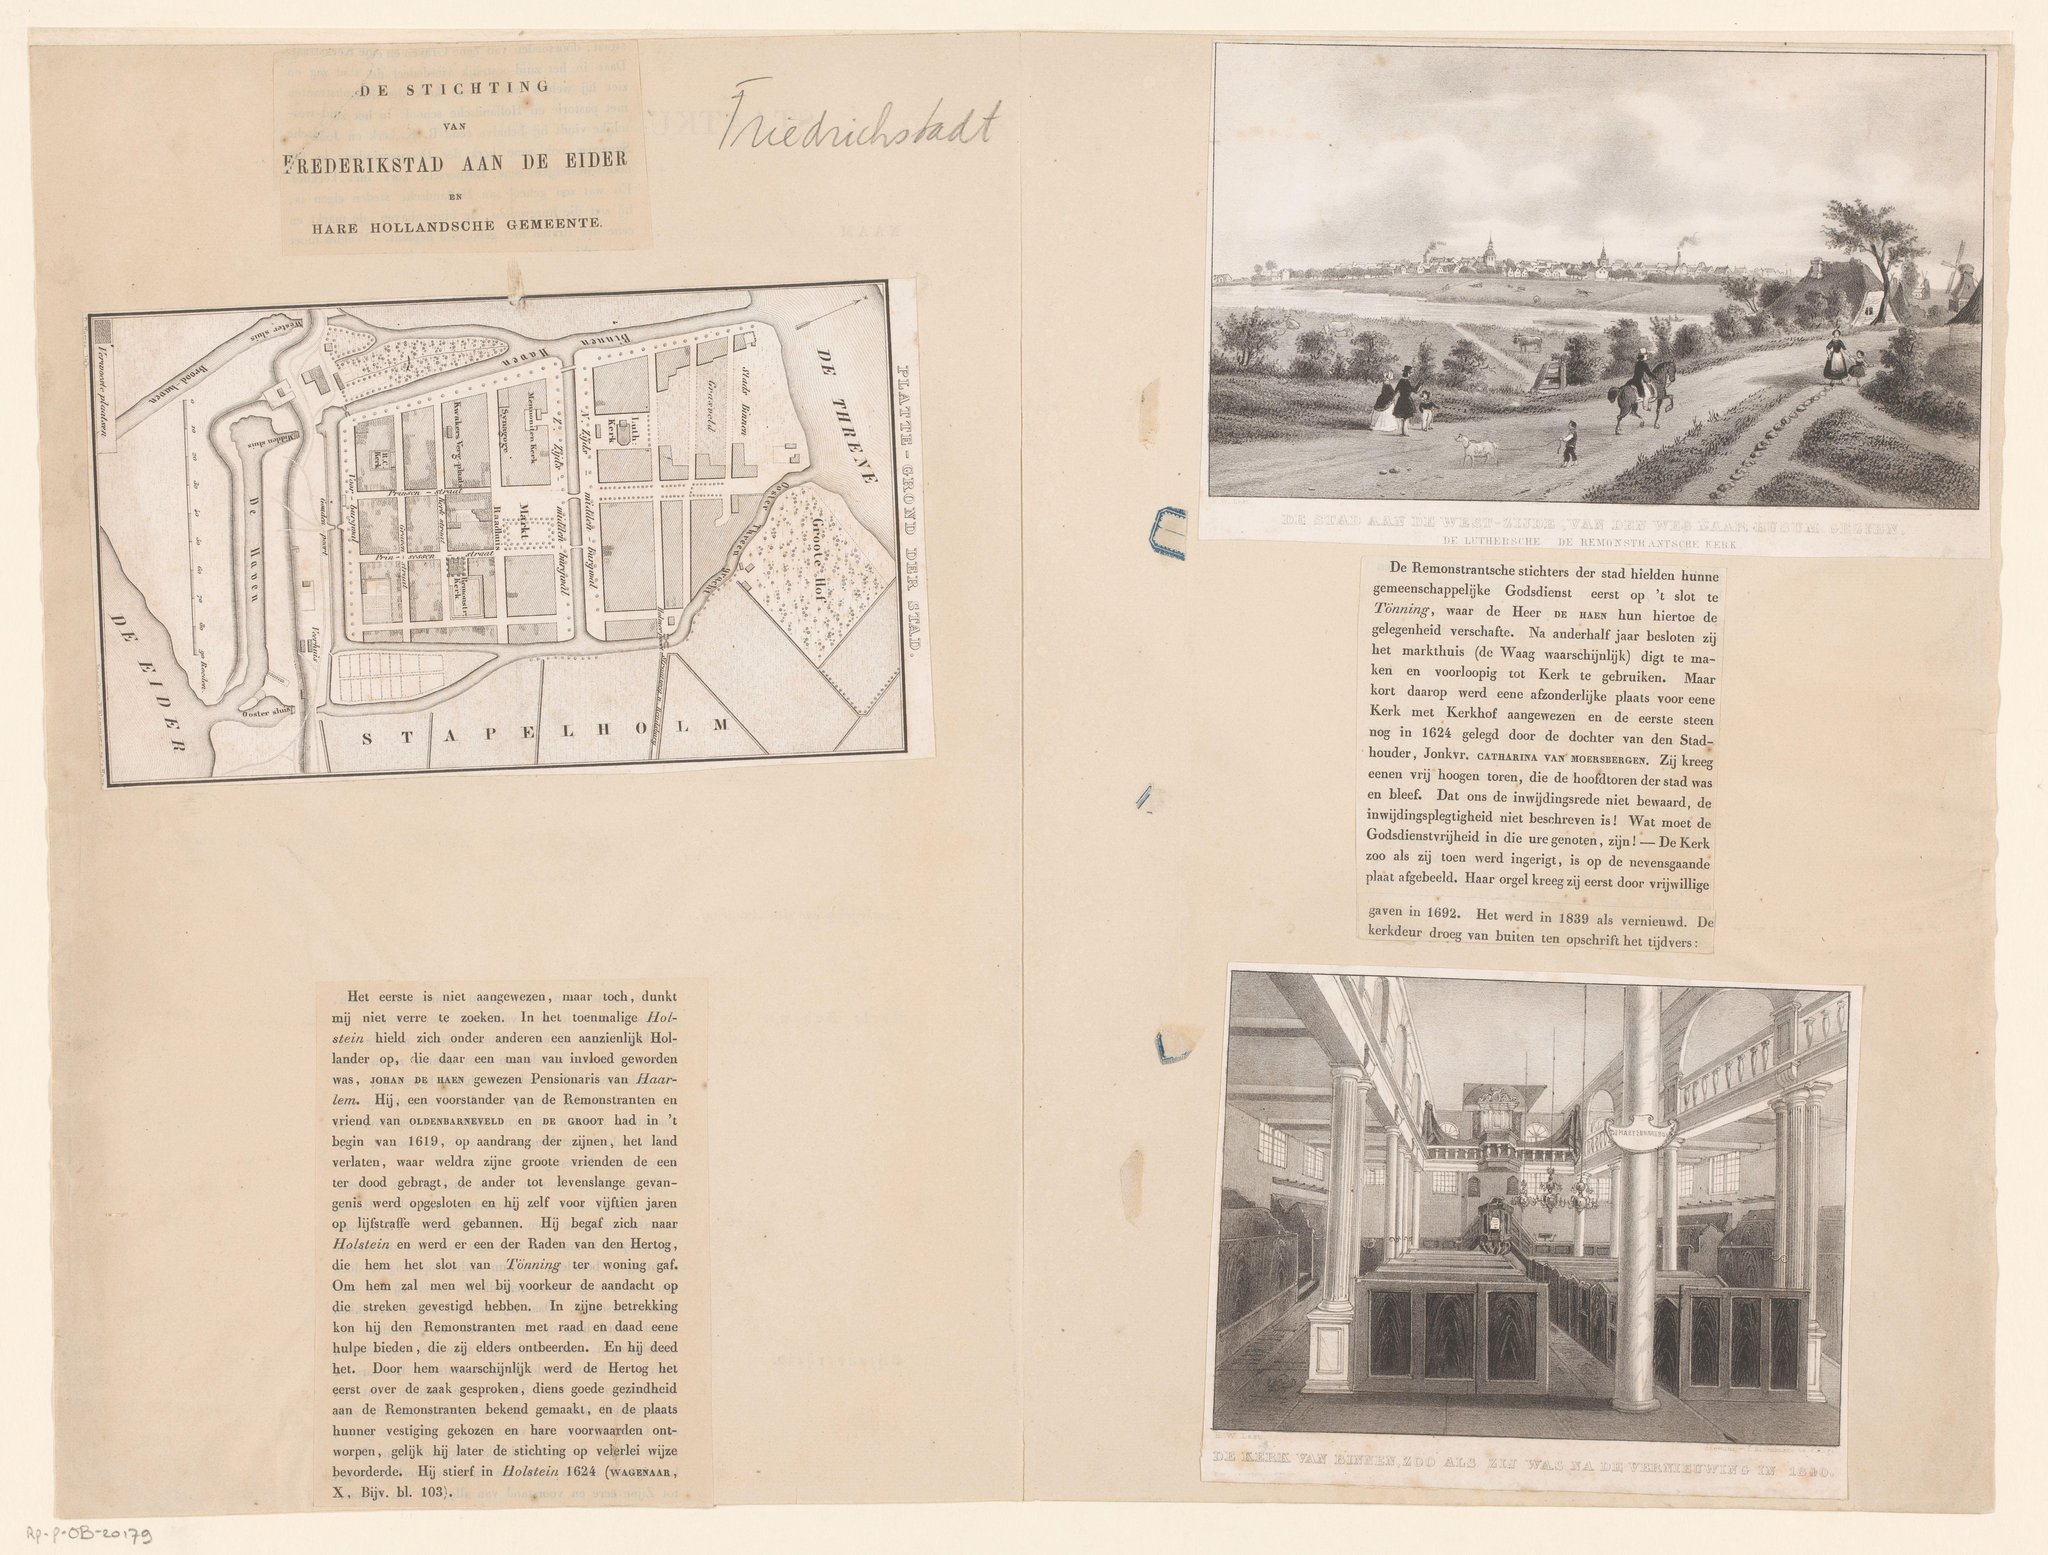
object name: print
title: De stichting van Frederikstad aan de Eider en hare Hollandsche gemeente / De stad aan de west-zijde, van den weg naar Husum gezien (...) / De kerk van binnen, zoo als zij was na de vernieuwing in 1840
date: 1842-1887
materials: paper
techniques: letterpress printing, lithograph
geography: the hague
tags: interior of church, maps of cities, prospect of city, town panorama, silhouette of city